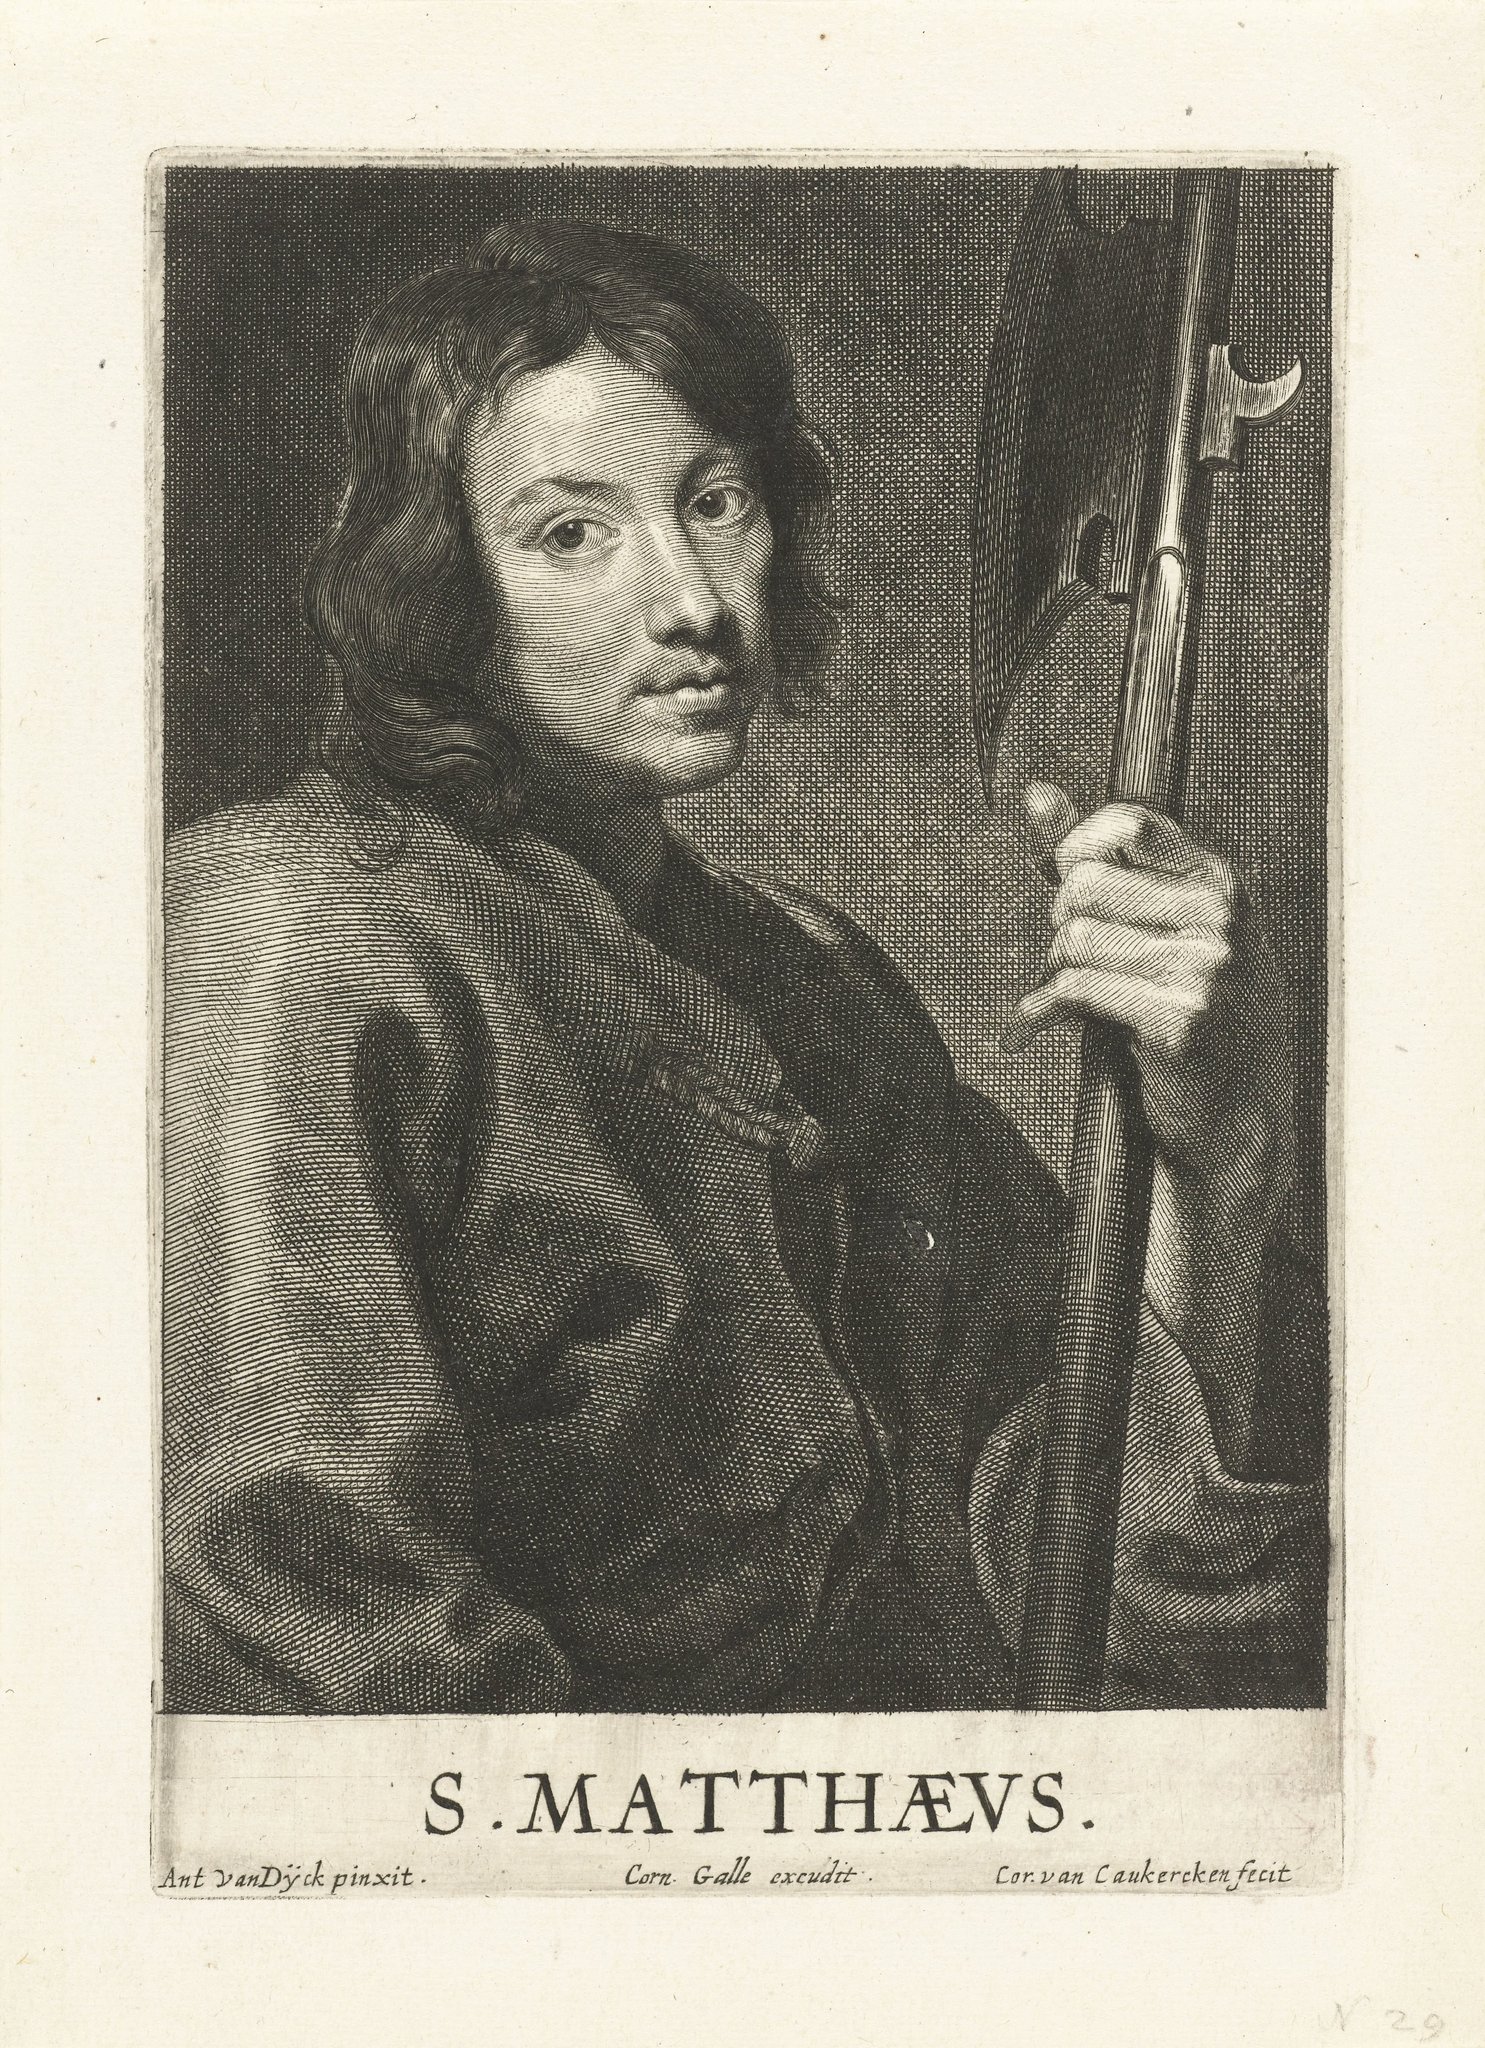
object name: print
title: Matteüs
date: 1640-1680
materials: paper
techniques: engraving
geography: antwerp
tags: the apostle and evangelist matthew (mattheus); possible attributes: angel, axe, book, halberd, pen and inkhorn, purse, scroll, square, sword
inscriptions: collector's mark: Lugt 240